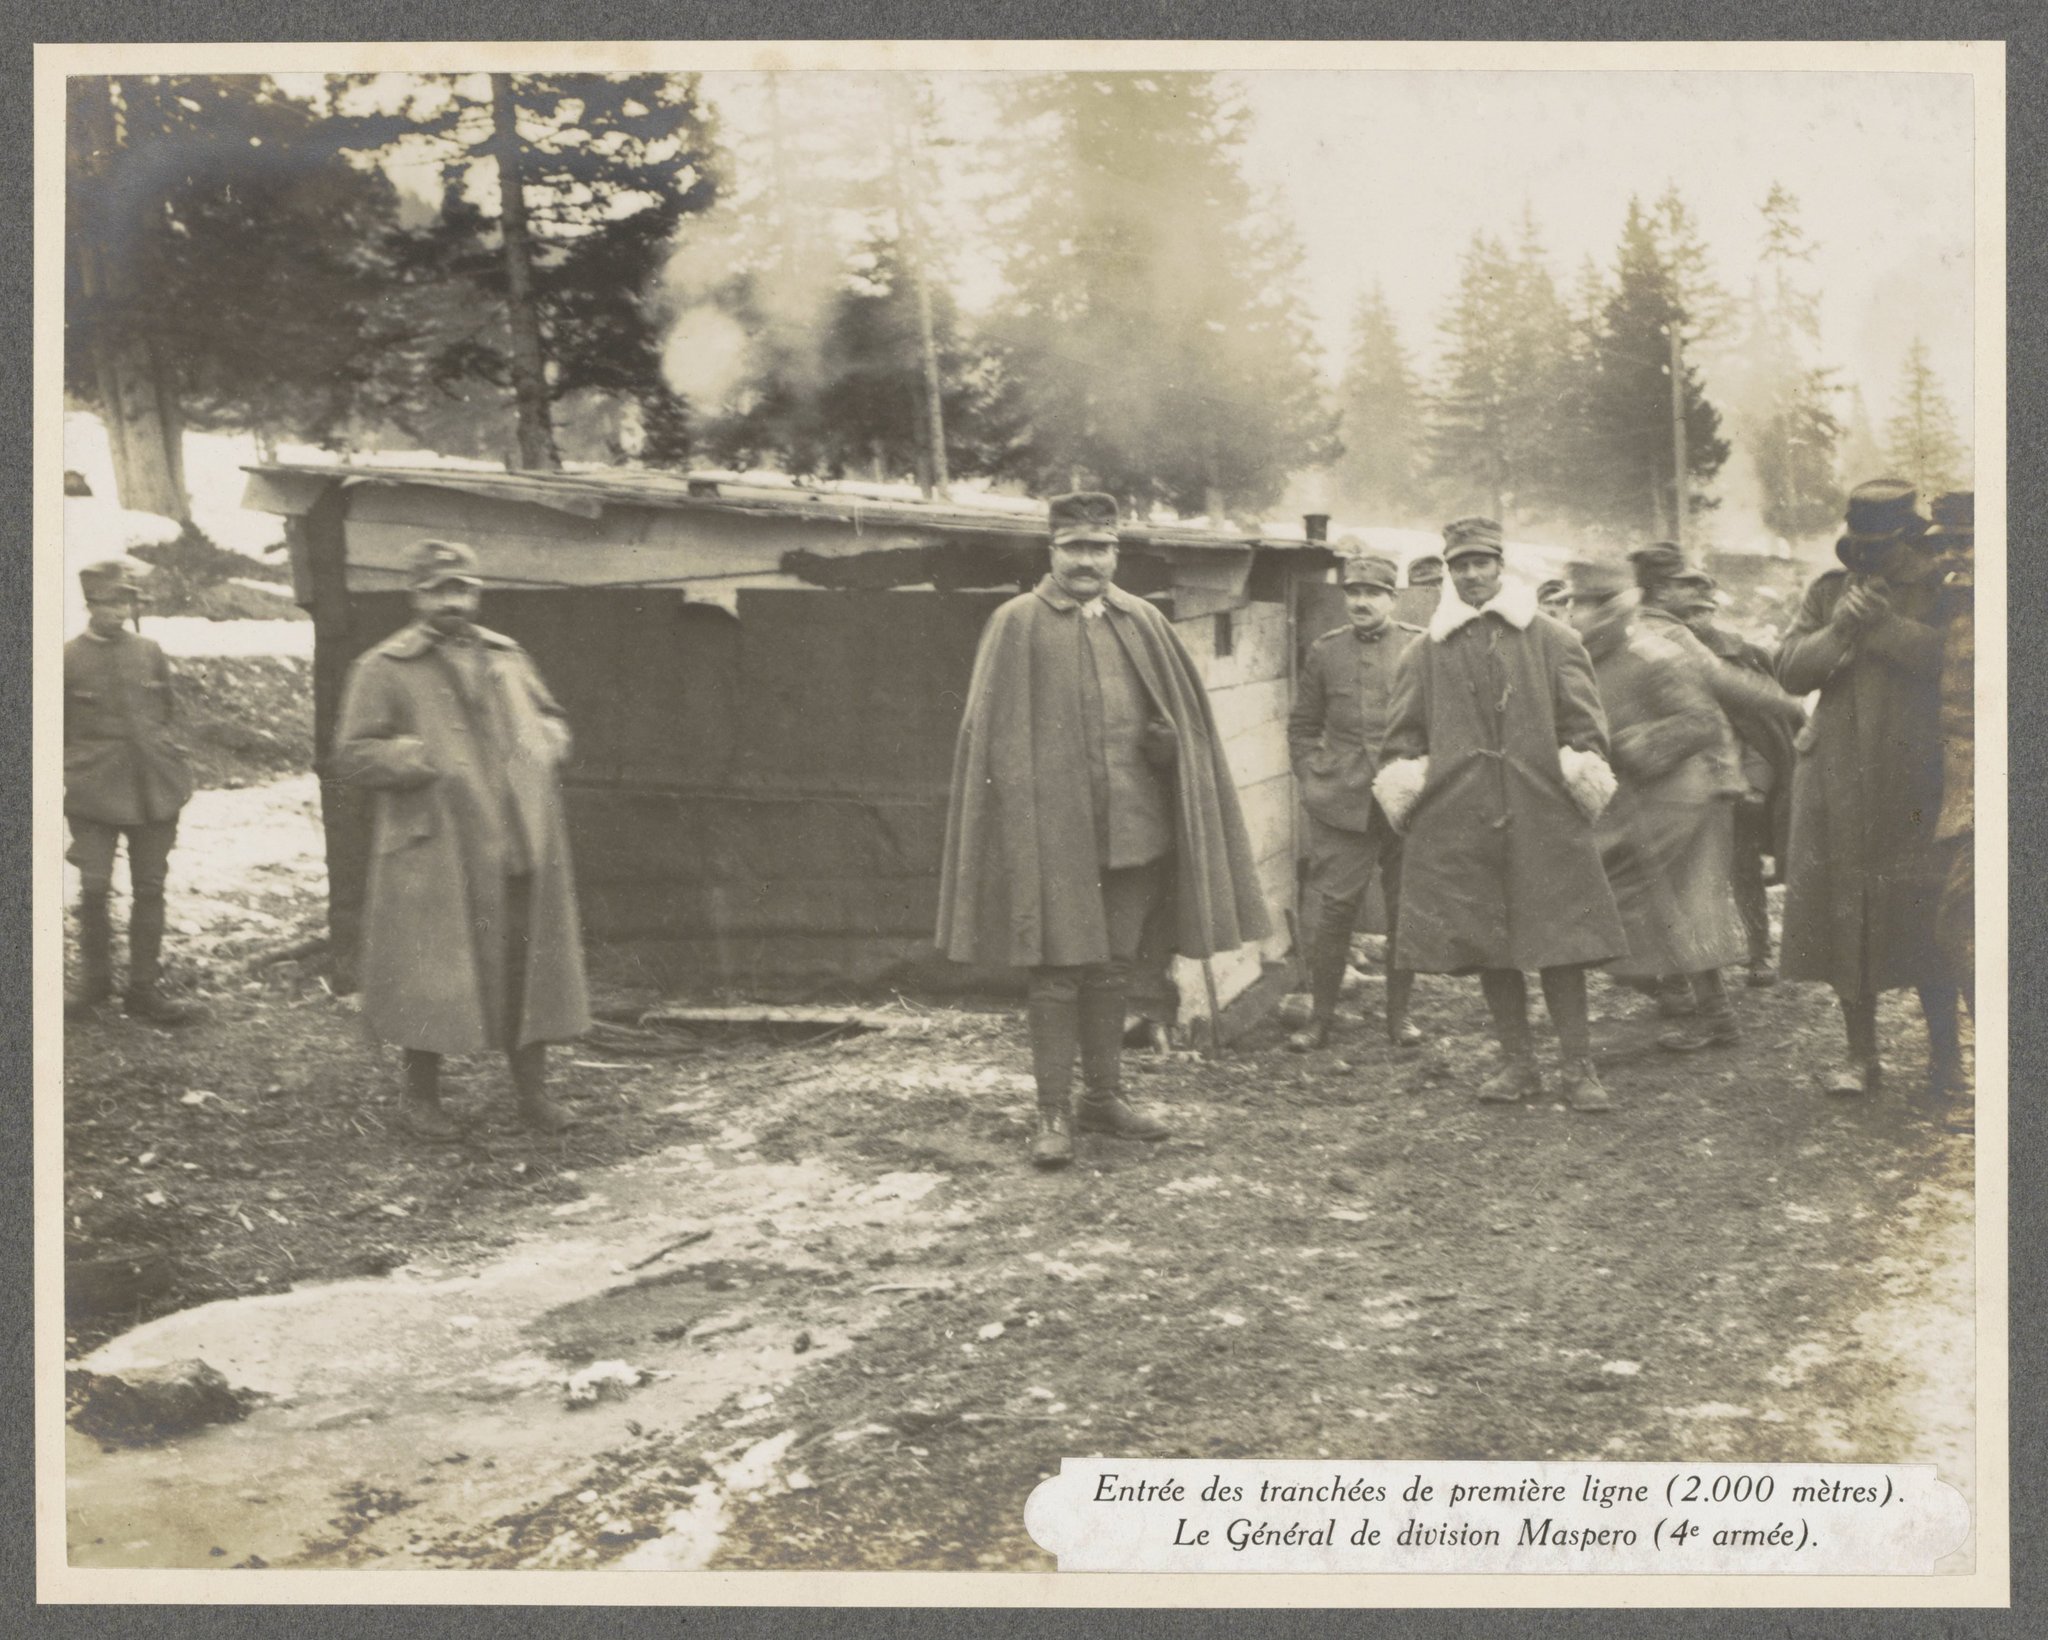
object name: photograph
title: Entrée des tranchées de première ligne (2.000 mètres). Le Général de division Maspero (4e armée).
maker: henri de rothschild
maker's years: 1872-1947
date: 1916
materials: photographic support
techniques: gelatin silver print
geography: dolomites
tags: war (+ land forces), commander-in-chief, general, marshal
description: Foto genomen op 2000 meter hoogte. Divisiegeneraal Maspero van het Vierde Leger in het midden. Onderdeel van Fotoalbum Medische missie H. de Rothschild naar het Italiaanse front 1916.